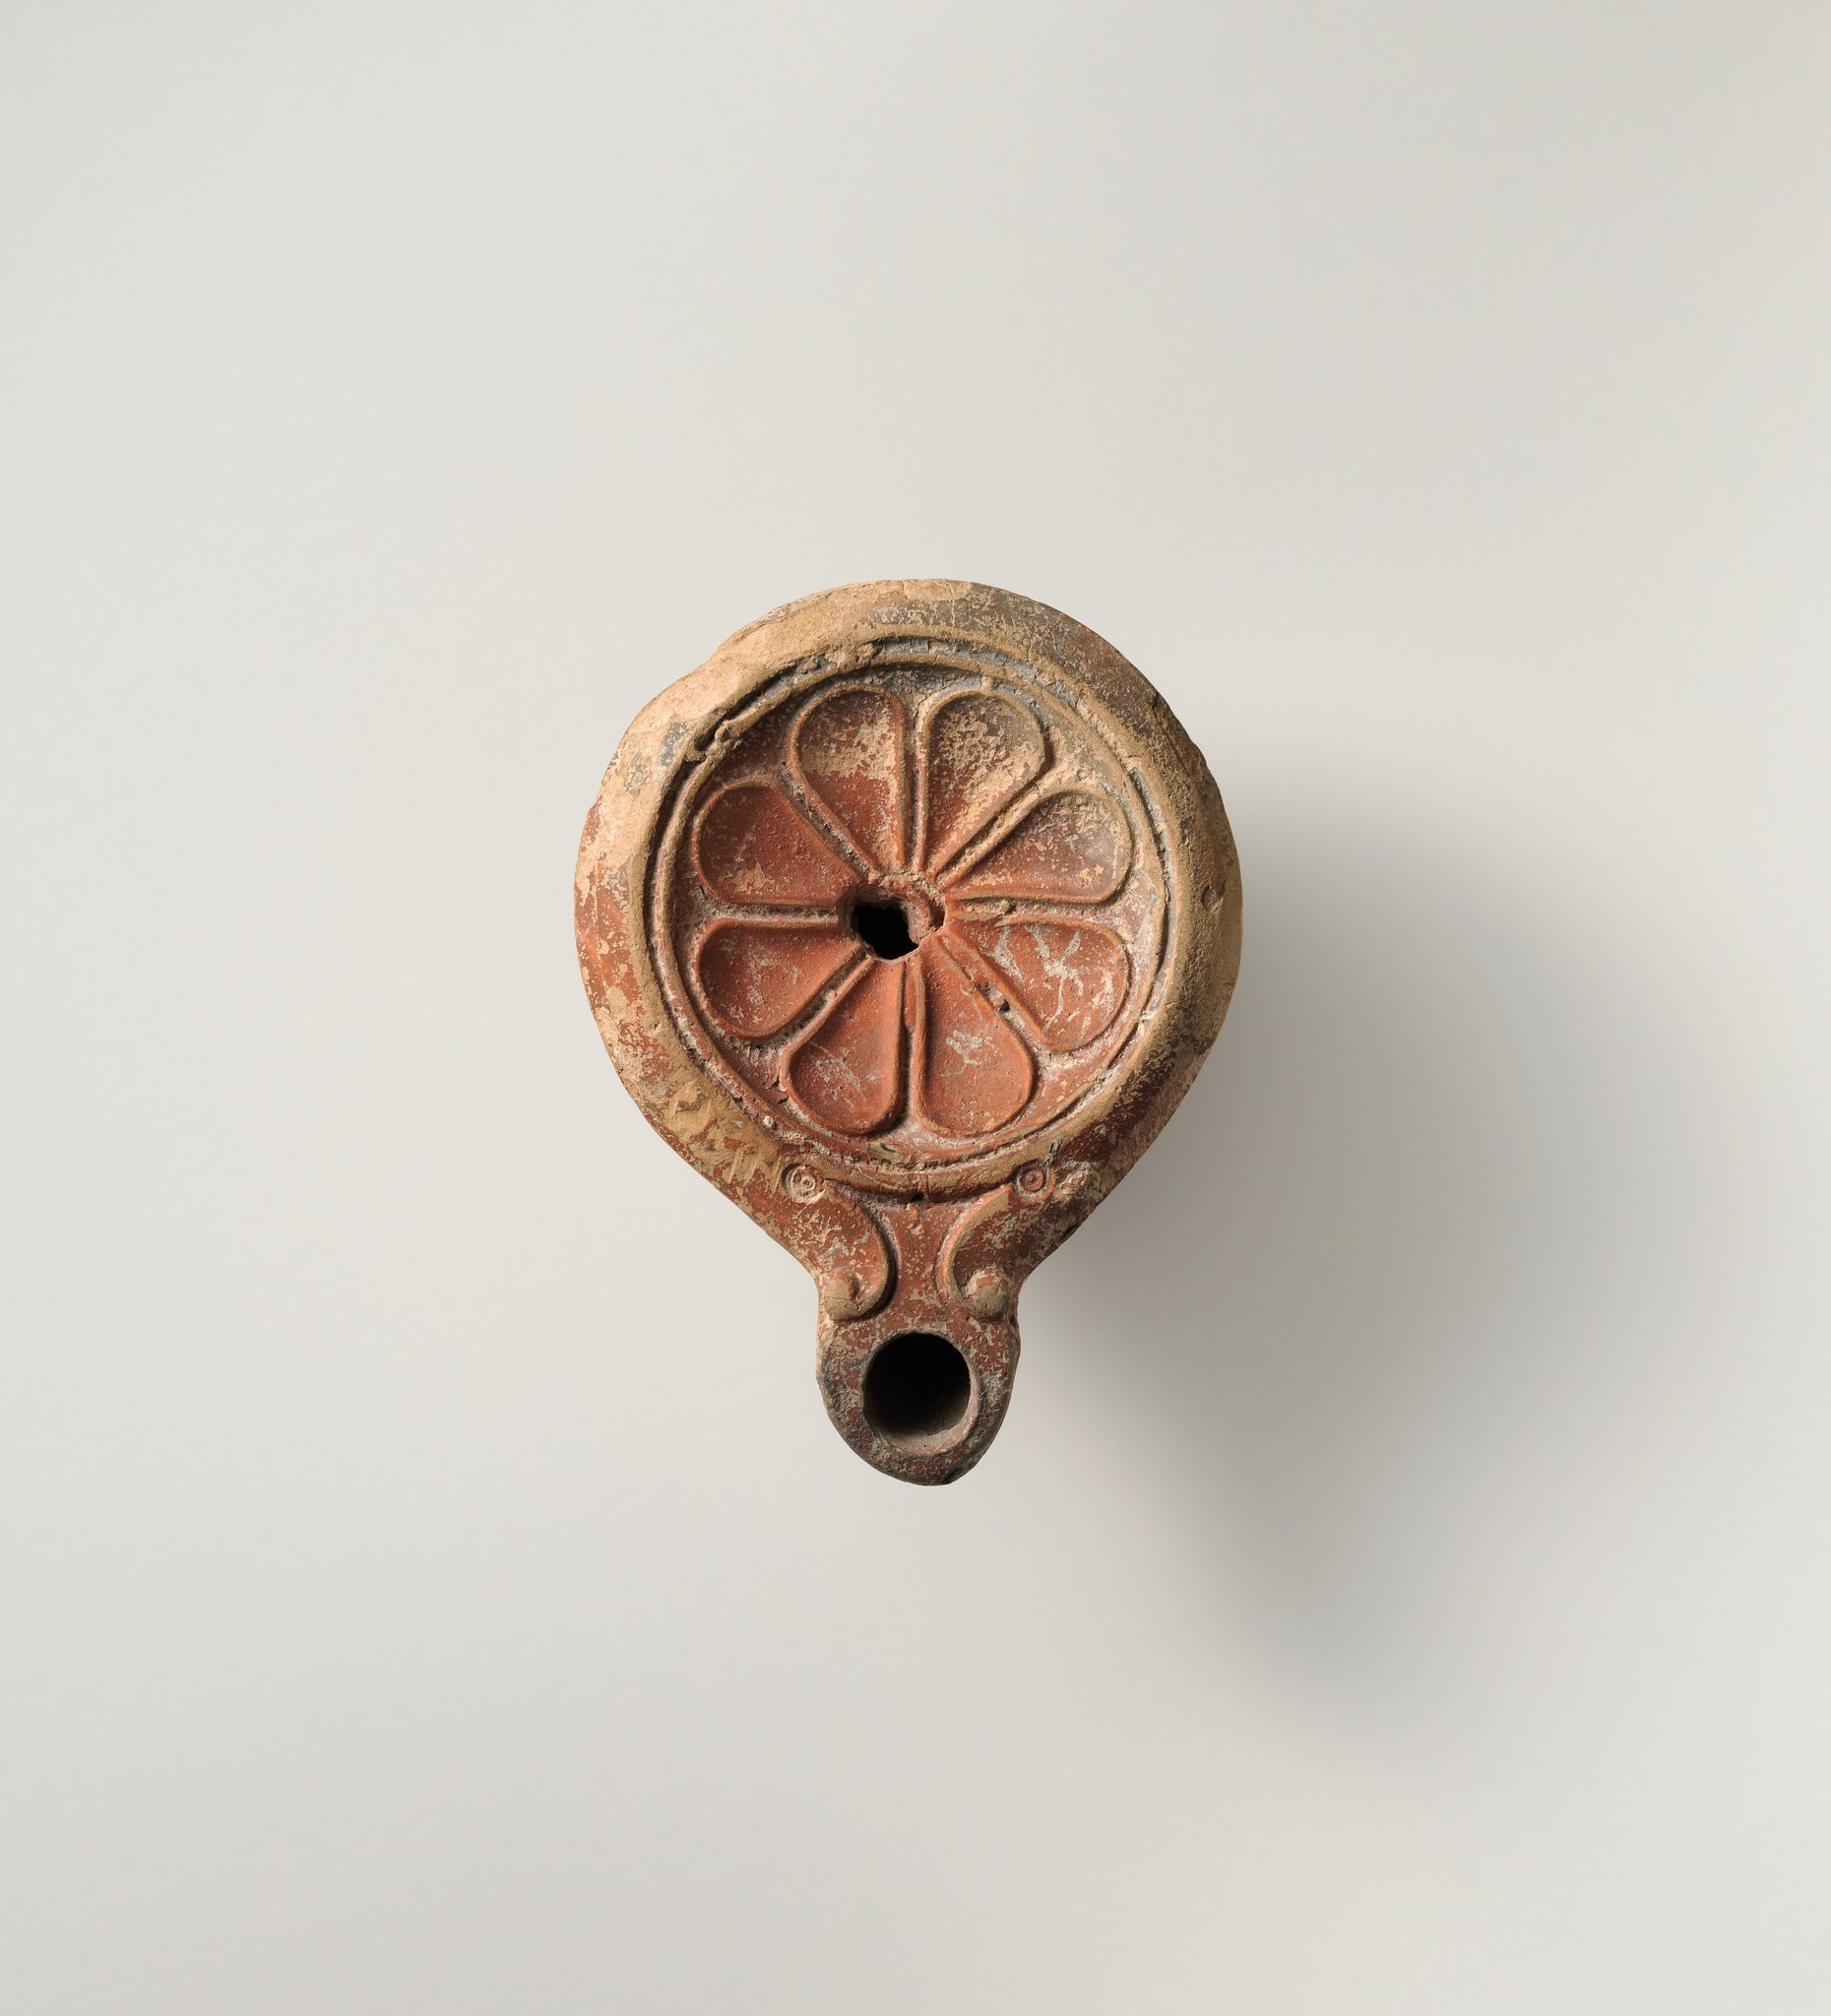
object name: lamp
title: Terracotta oil lamp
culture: roman, cypriot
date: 50-100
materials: terracotta